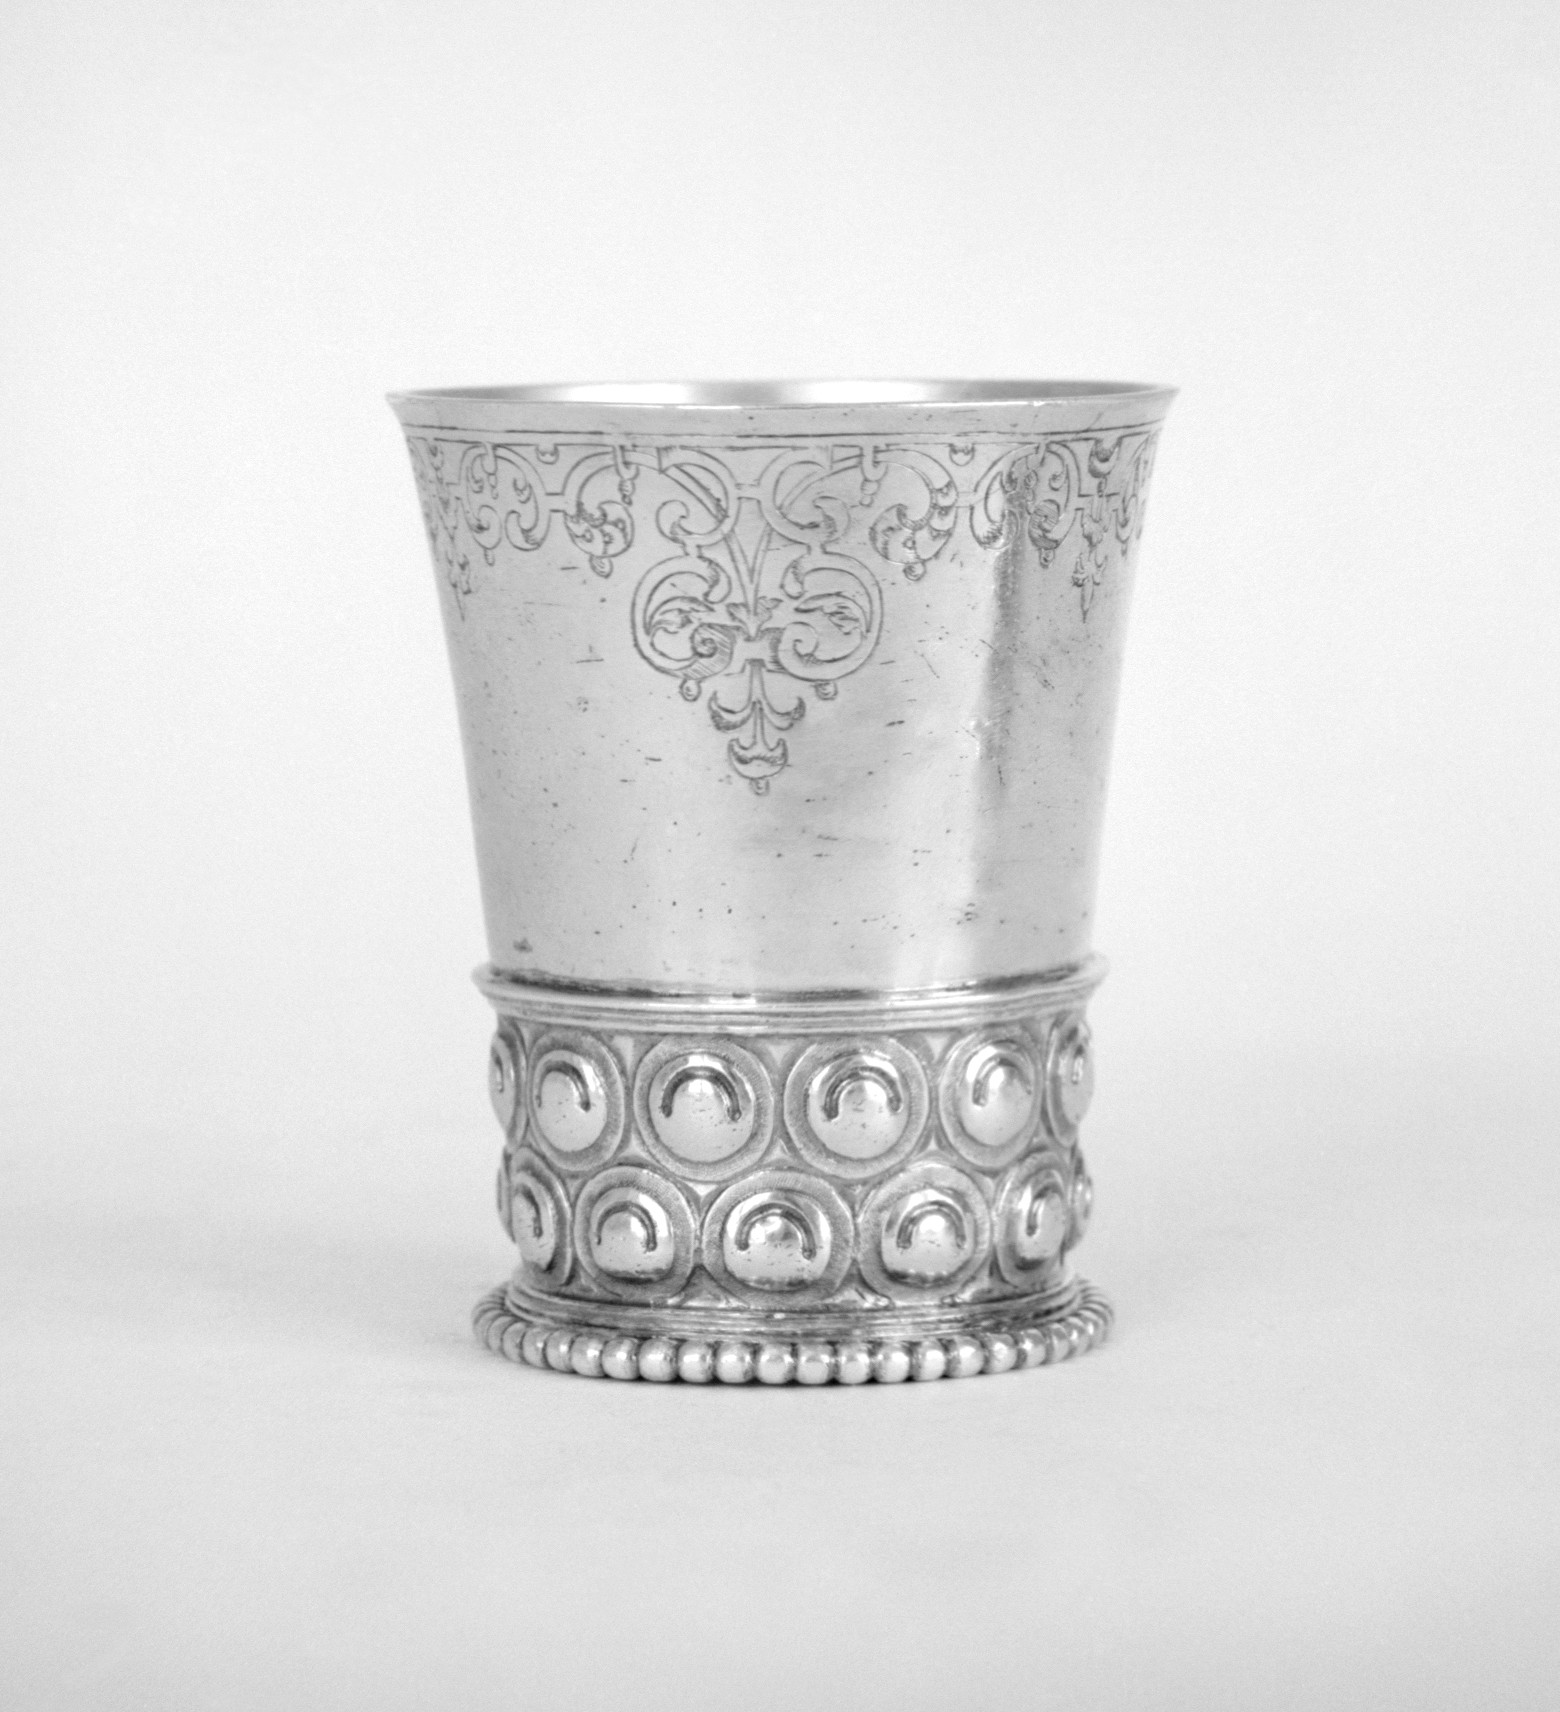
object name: beaker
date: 1646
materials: silver gilt